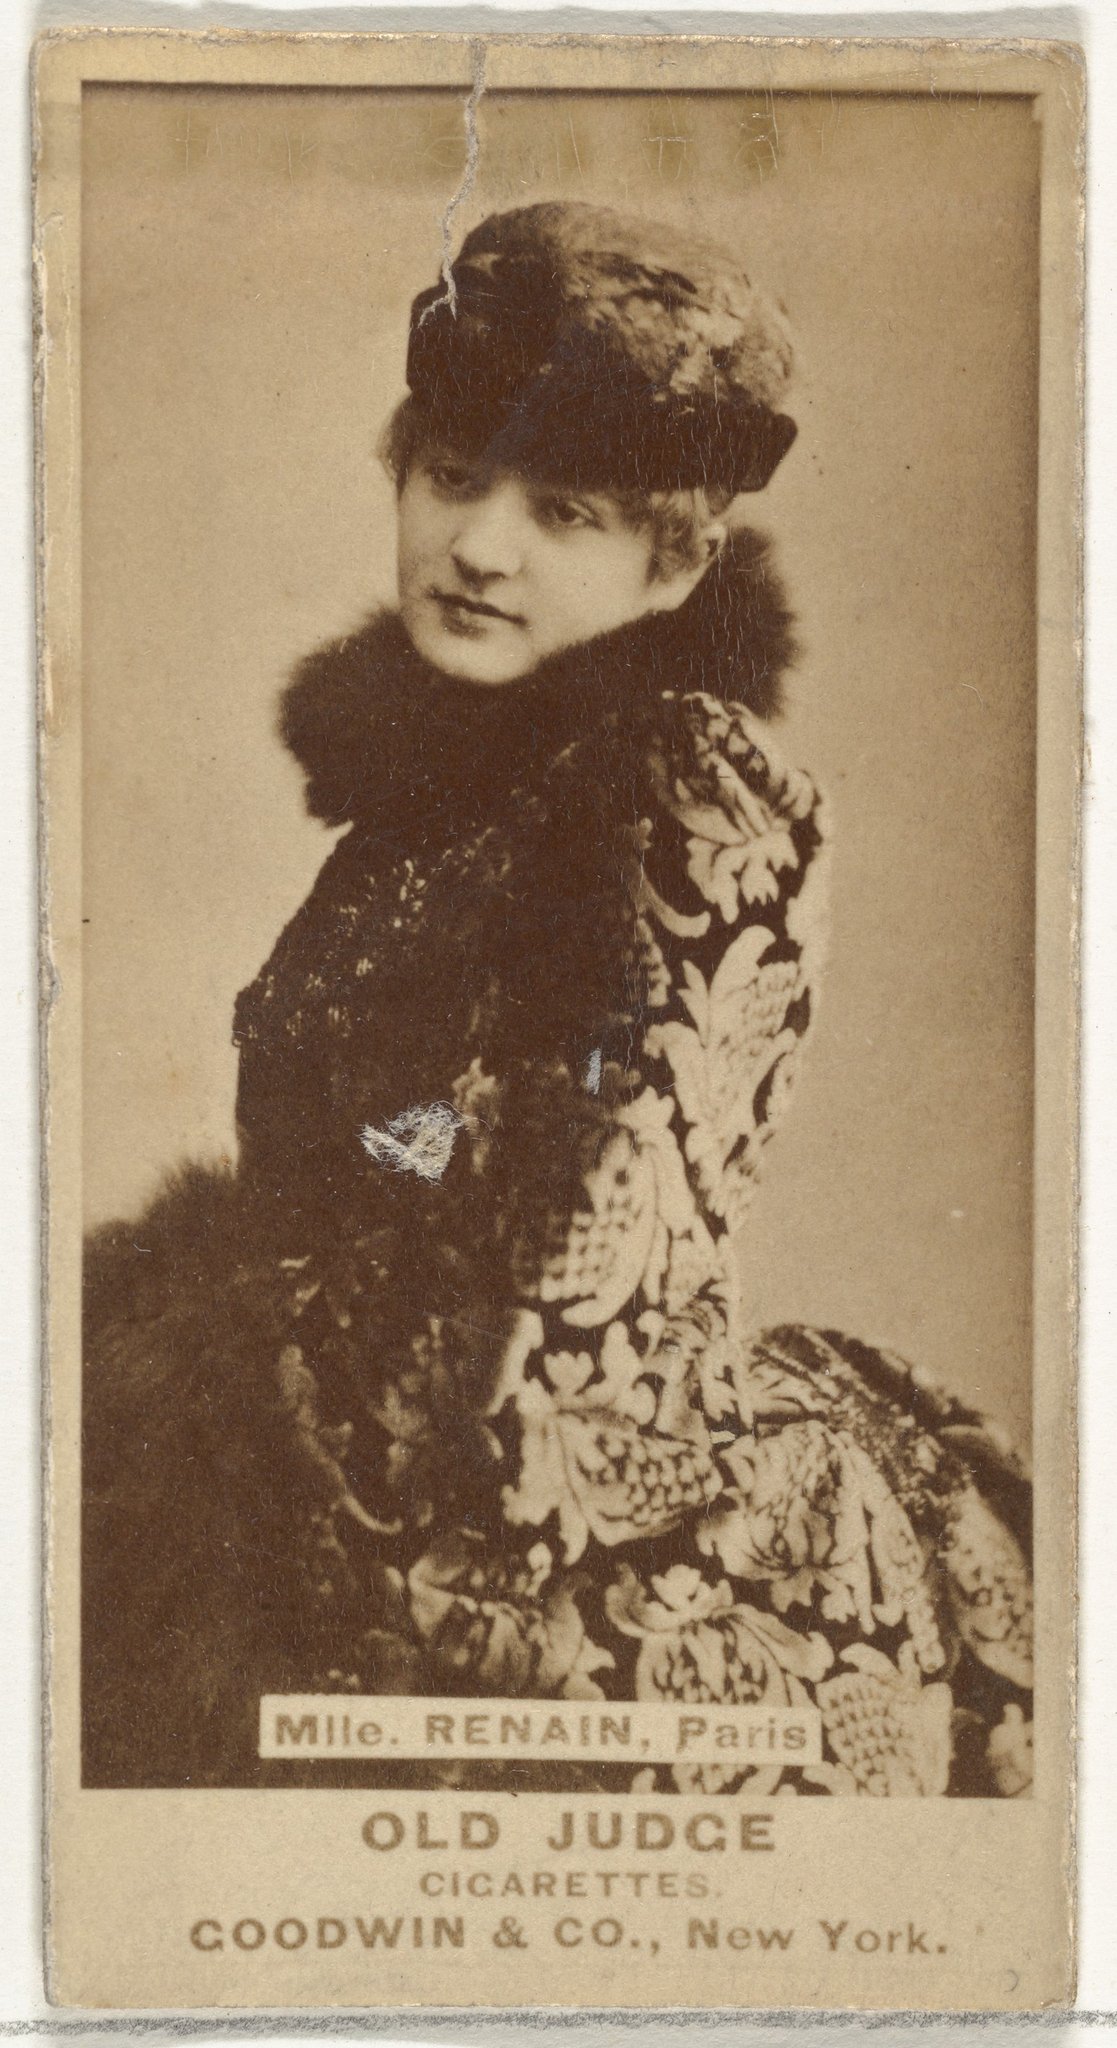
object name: photograph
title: Mlle. Renain, Paris, from the Actors and Actresses series (N171) for Old Judge Cigarettes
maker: goodwin & company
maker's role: publisher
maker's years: 1850-1950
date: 1886-1890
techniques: albumen silver print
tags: portraits,women,actresses